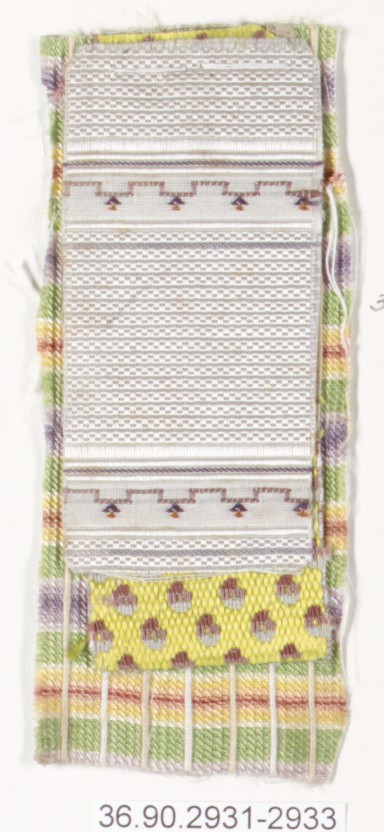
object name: piece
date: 1801-1900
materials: silk